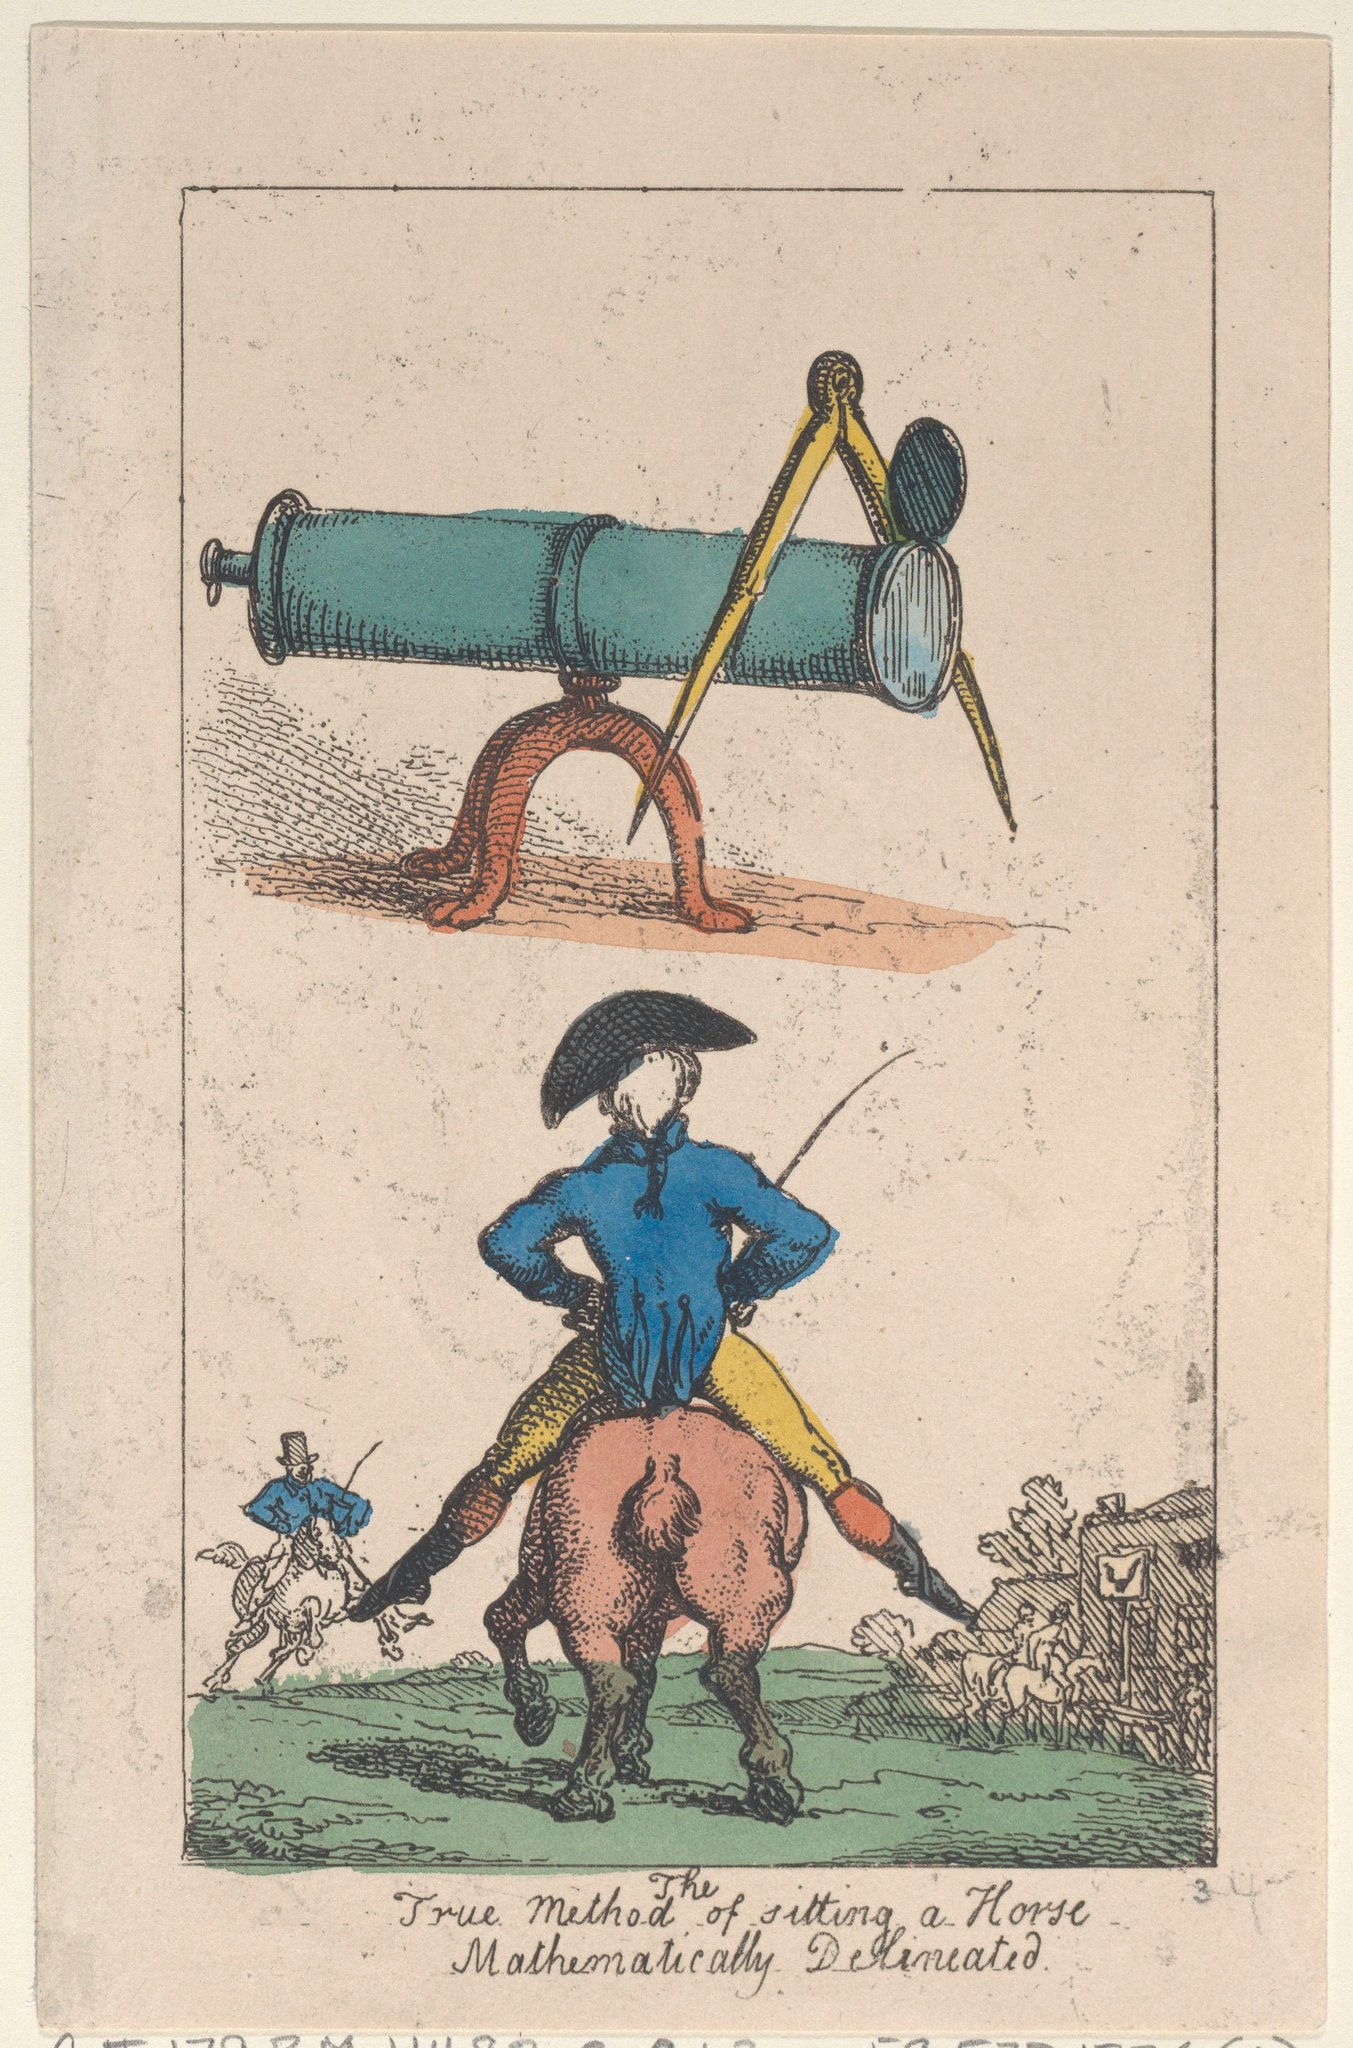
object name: print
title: The True Method of Sitting a Horse, Mathematically Delineated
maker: thomas rowlandson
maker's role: artist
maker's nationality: british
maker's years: 1757-1827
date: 1809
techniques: etching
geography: london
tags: satire,horses,telescopes